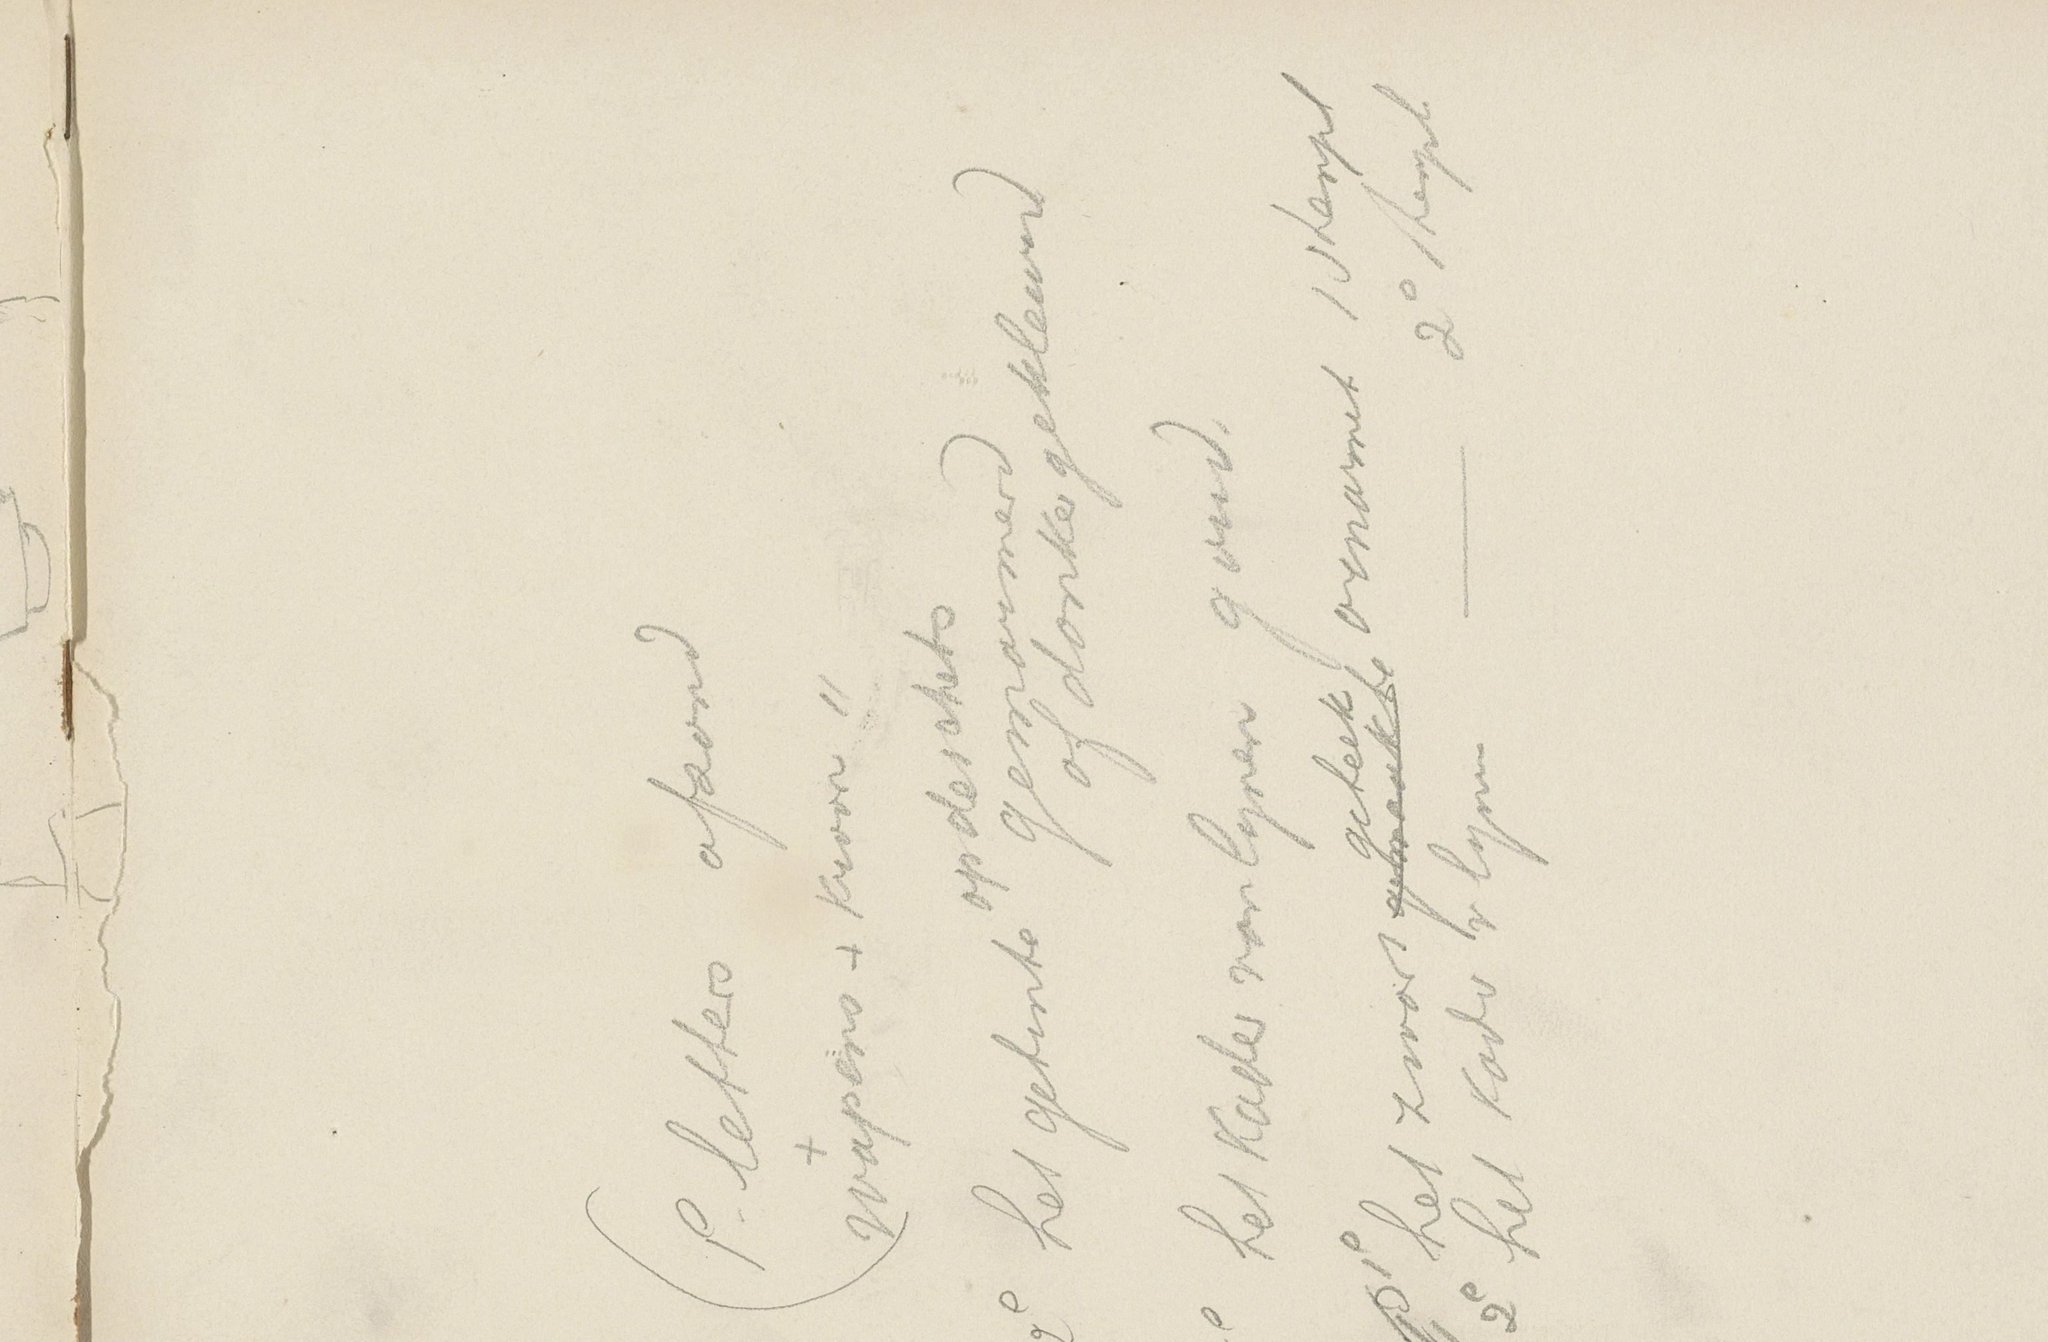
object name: sketchbook leaf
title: Notities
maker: carel adolph lion cachet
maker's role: draughtsman, print maker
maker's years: 1864-1945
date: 1908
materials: paper, pencil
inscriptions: annotation: ‘P-letters af[...]ond/ +/ wapens + kroon ''/ 2e het getinte op de schets gemarmerd/ of donker gekleurd/ 3e het kader van lijnen goud./ [...] het zwart geteek ornament 1 ste[...]/ 2e het kader v lijnen - 2 [...]’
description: Blad 13 recto uit een schetsboek met 25 bladen.